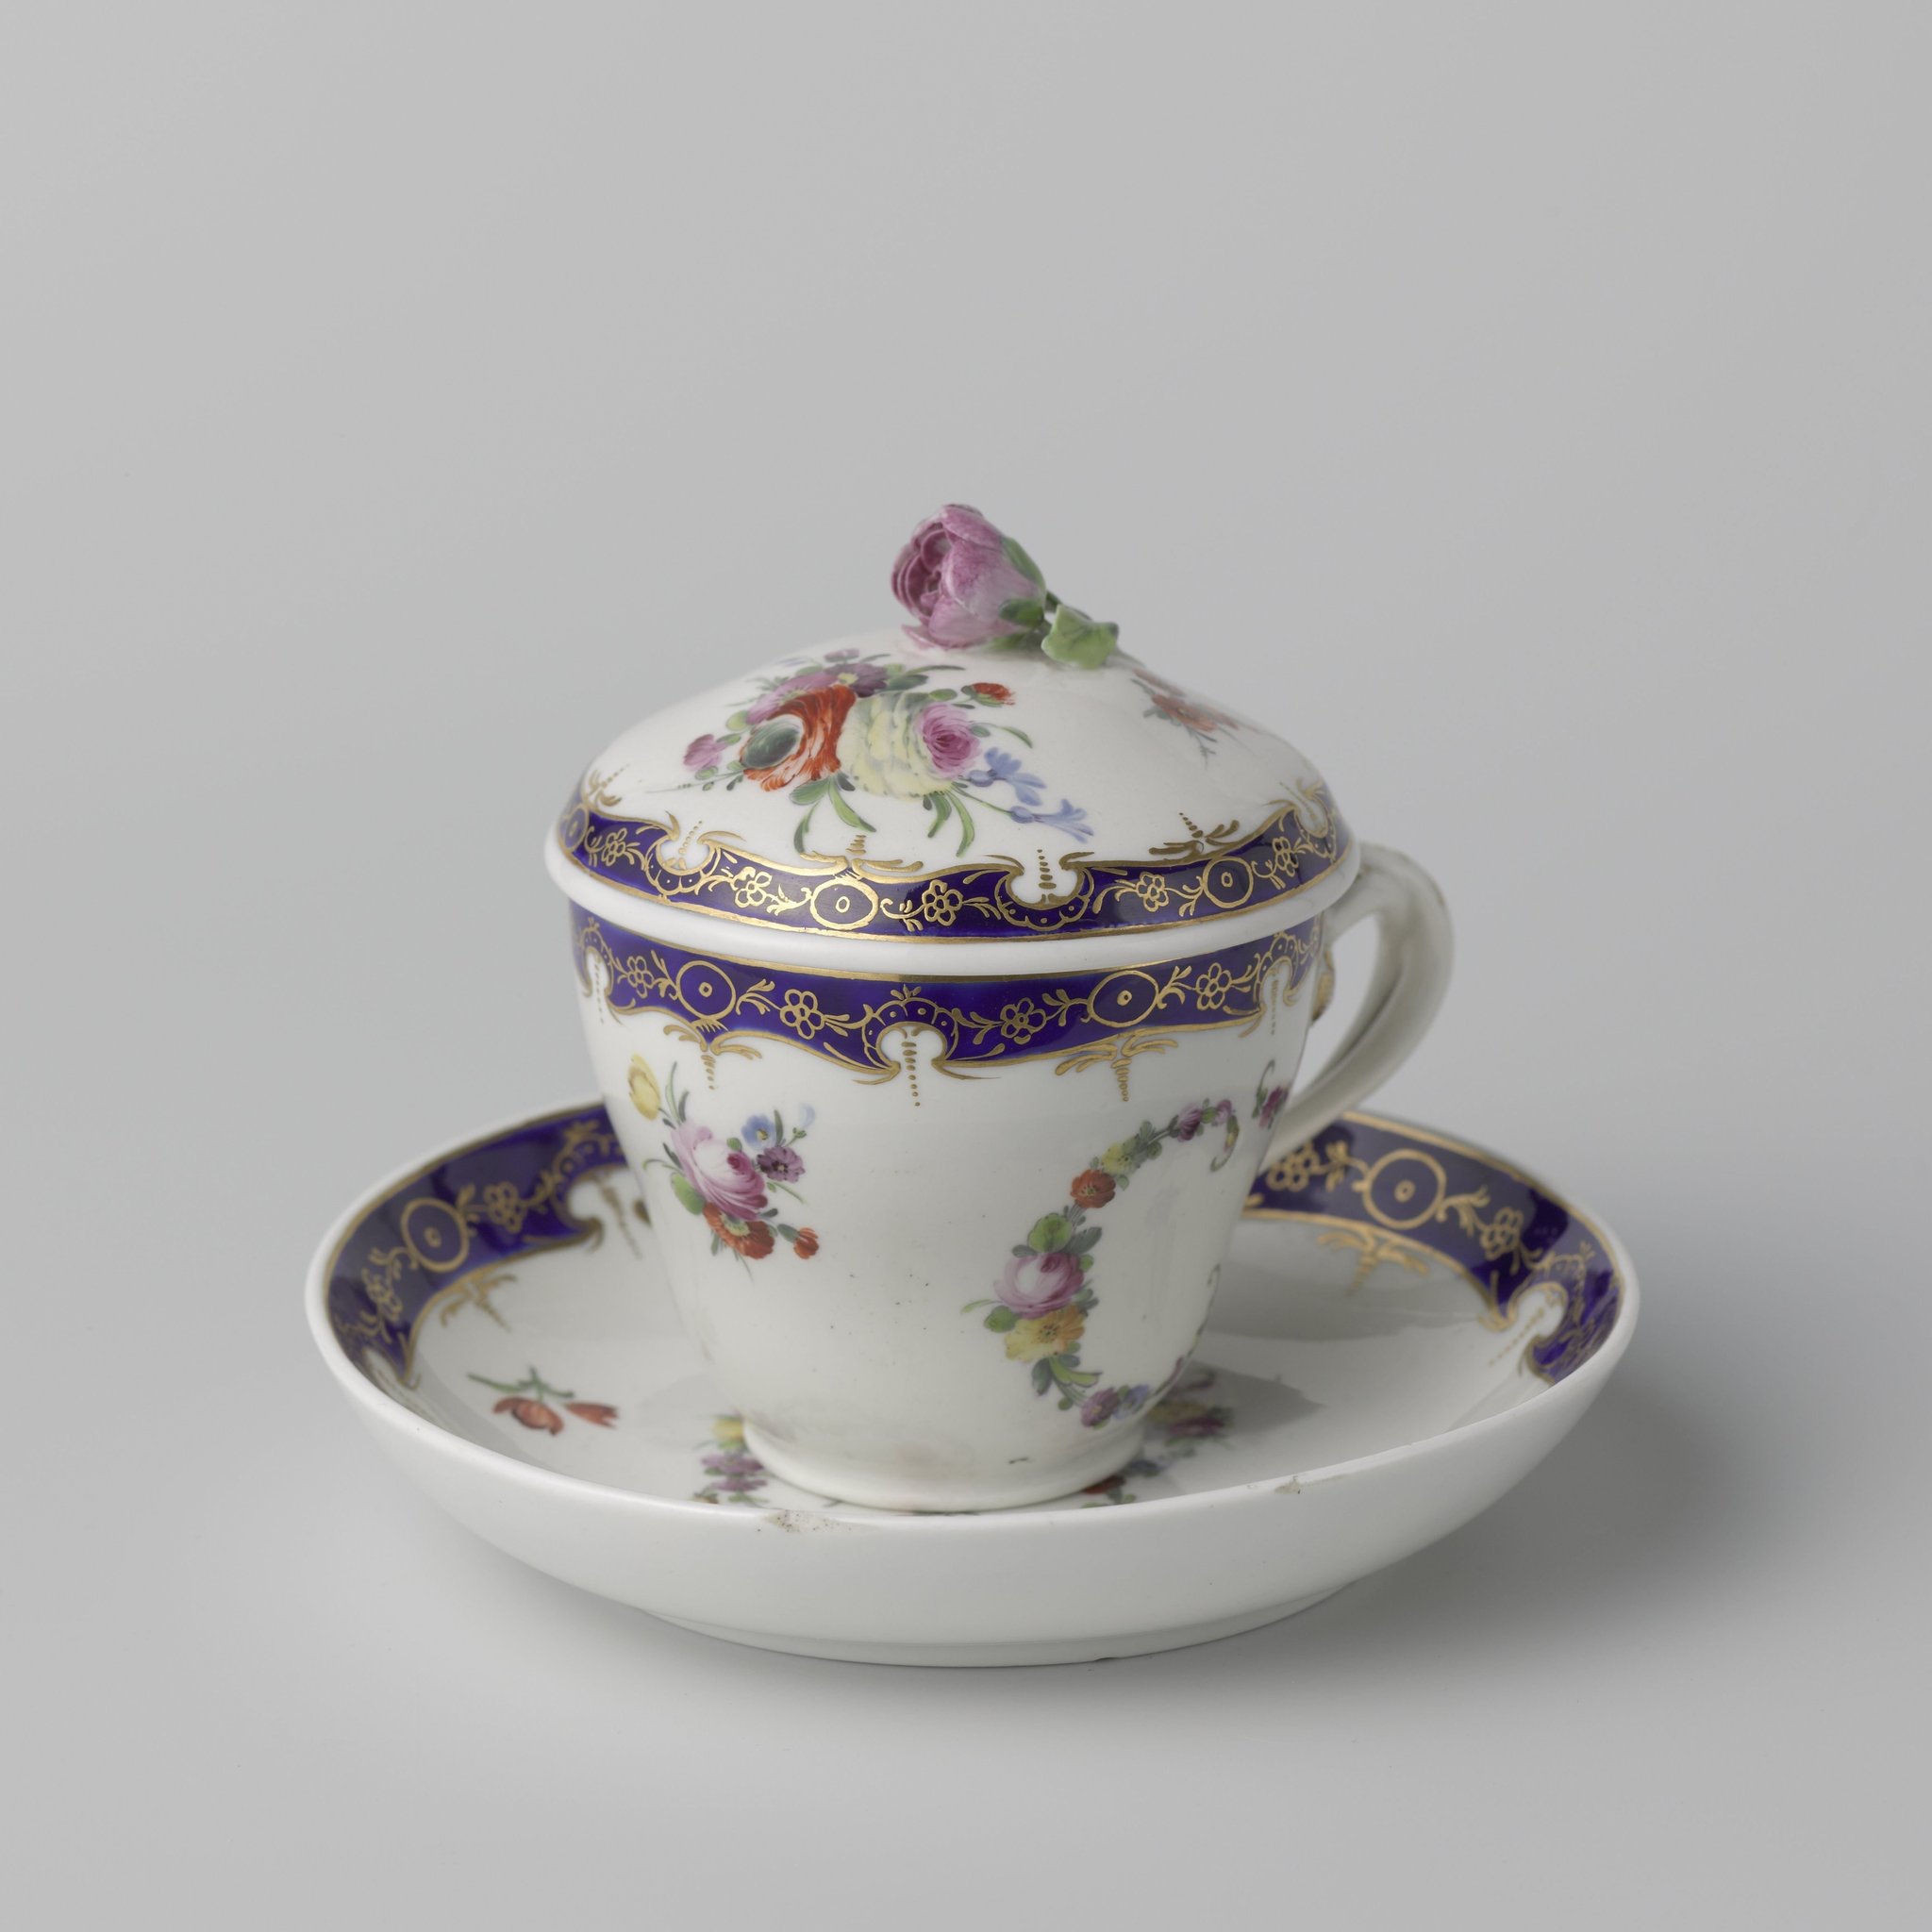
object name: cup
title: Chocolate cup and saucer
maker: Anonymous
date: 1785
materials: porcelain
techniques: painted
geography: doornik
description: Tournai painted decoration: Porseleinfabriek Den Haag, 1785 soft-paste porcelain (pâte-tendre)